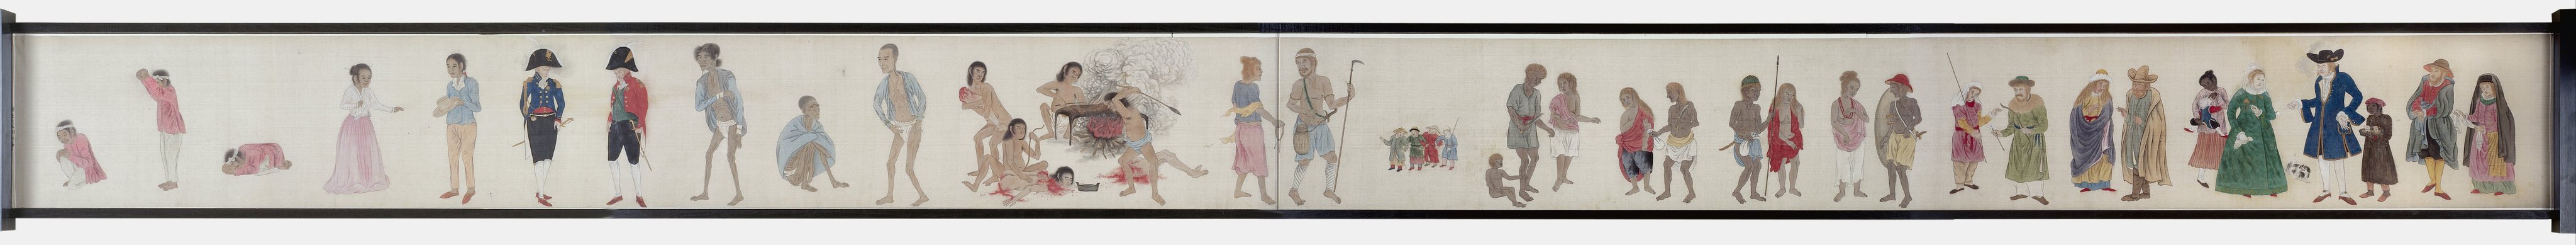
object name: emakimono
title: Nederlanders en vreemdelingen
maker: ishizaki yushi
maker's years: 1768-1846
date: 1800-1850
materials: ivory, paper, silk, wood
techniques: painted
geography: nagasaki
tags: europeans (with name), japan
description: Foreigners. Makimono (handscroll), by Ishizaki Yushi, first half 19th century. The Japanese artist who painted this makimono, depicted various foreign types. In the centre is a group of cannibals. To the left are two European, probably Dutch, naval officers in early 19th-century uniform. Other Westerners, right, are wearing 18th-century dress. The couple are accompanied by a babu - a nursemaid - and a servant, probably from Java.